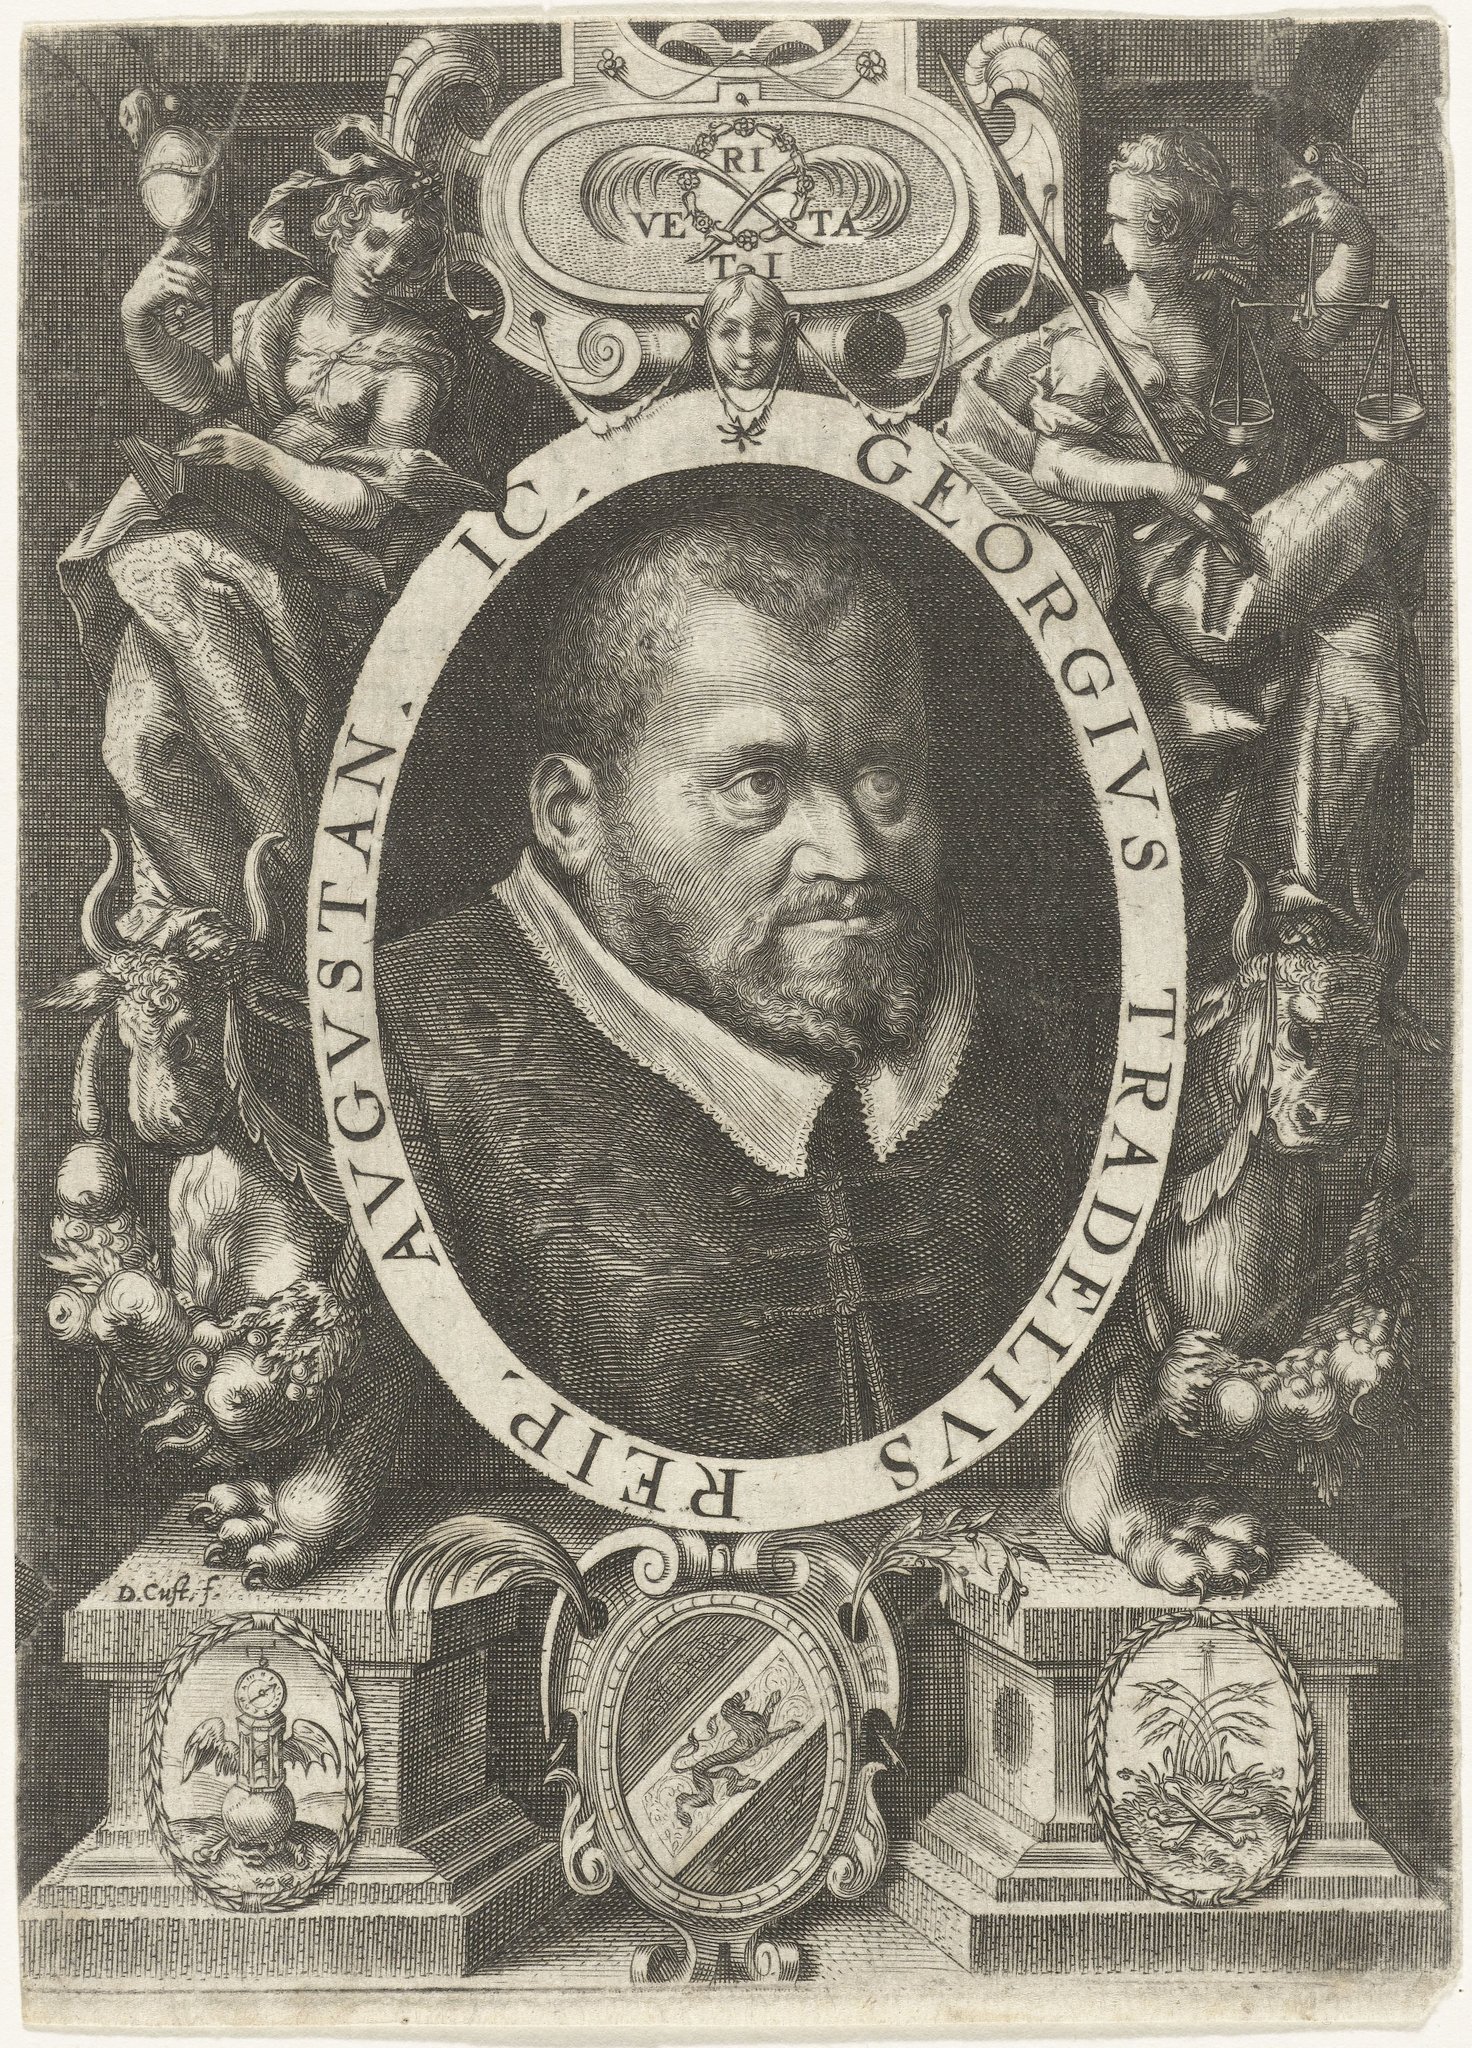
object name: print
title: Portret van de jurist Georg Tradel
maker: dominicus custos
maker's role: print maker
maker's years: 1560-1615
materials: paper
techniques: engraving, letterpress printing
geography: augsburg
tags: jurist, georg tradel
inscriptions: collector's mark: Lugt 2228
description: Portret van de Augsburgse jurist Georg Tradel, in ovaal met randschrift. Aan weerszijden Rechtvaardigheid en Voorzichtigheid zittend op ossen.